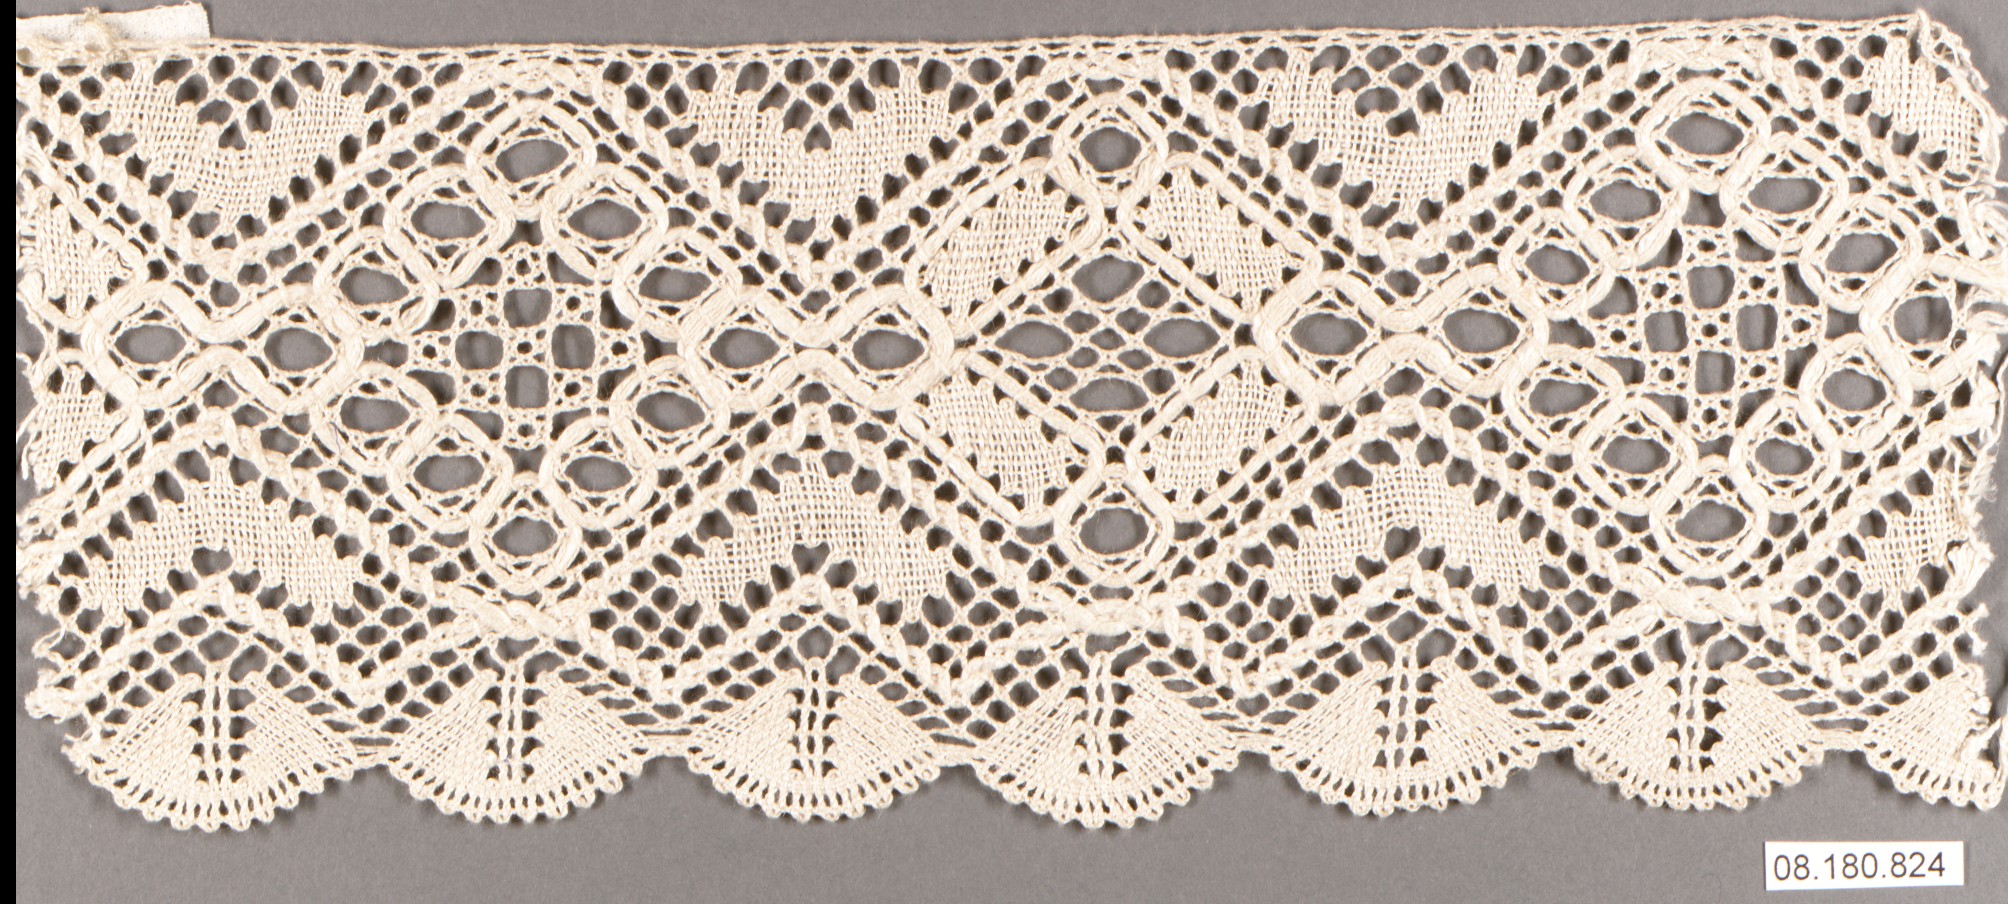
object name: fragment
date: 1801-1900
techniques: lace